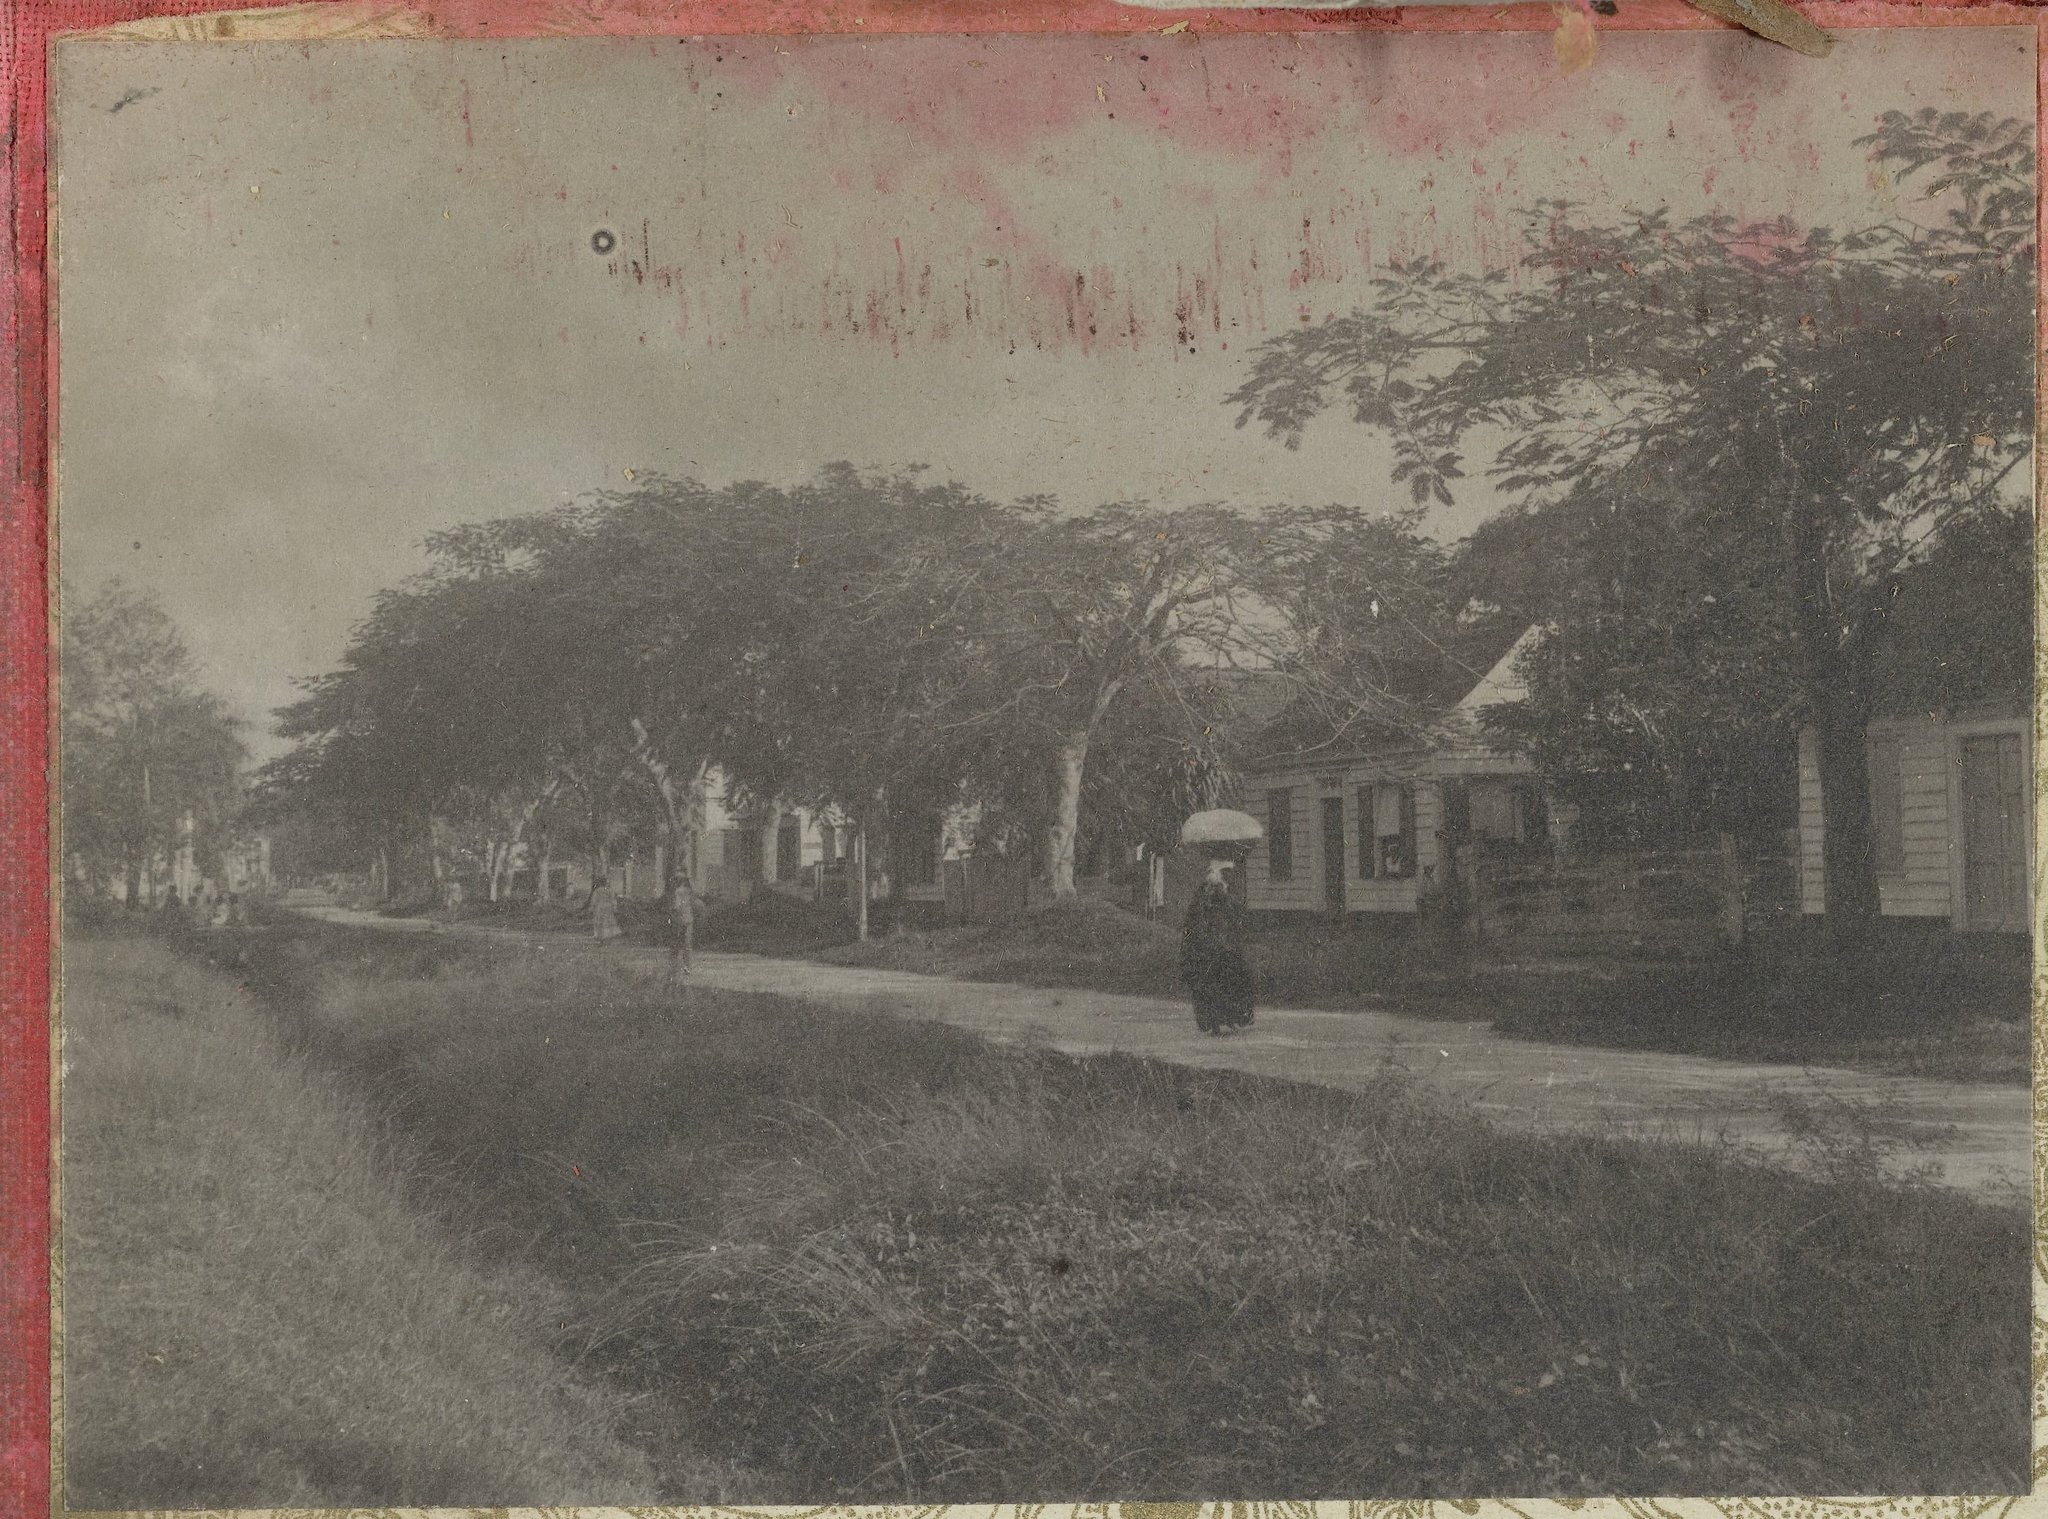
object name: photograph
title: Straat met huizen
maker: hendrik doijer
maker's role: engineer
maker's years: 1863-1925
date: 1903-1910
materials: photographic support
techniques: gelatin silver print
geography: suriname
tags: suriname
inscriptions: inscription: ‘115’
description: Gezicht op een straat met huizen (te Paramaribo?). Onderdeel van het fotoalbum Souvenir de Voyage (deel 1), over het leven van de familie Doijer in en rond de plantage Ma Retraite in Suriname in de jaren 1903-1910.